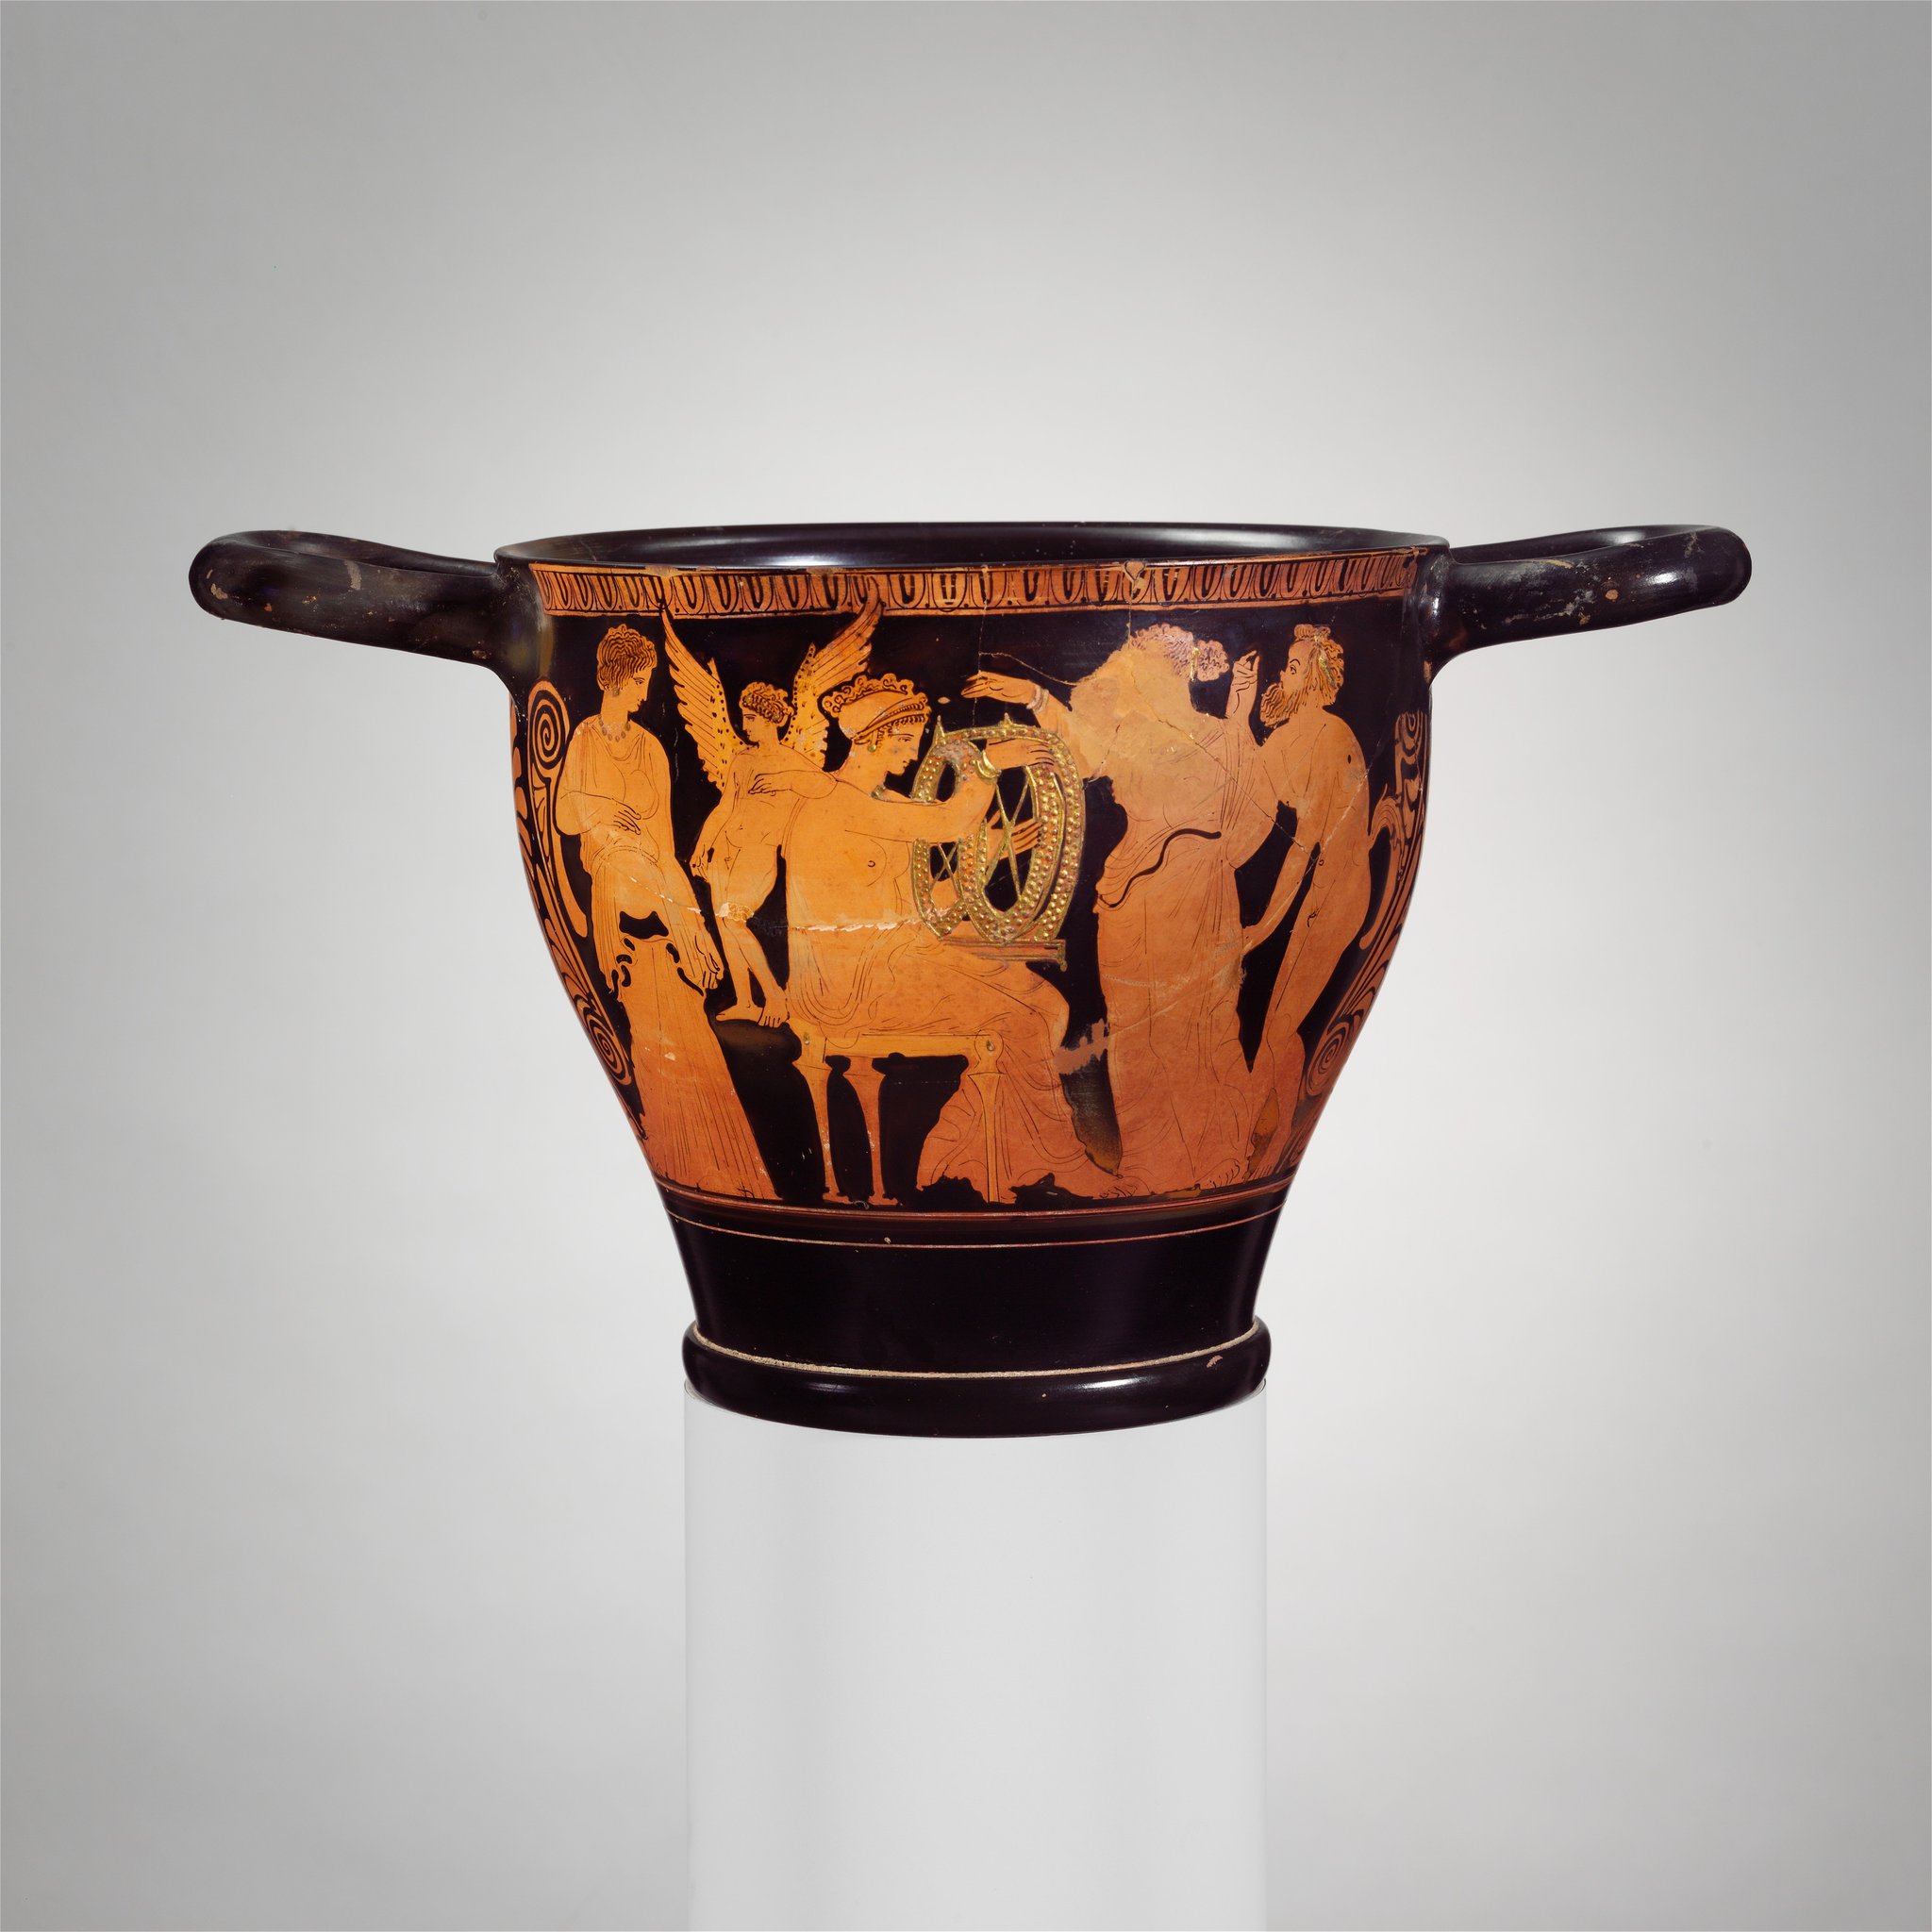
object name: skyphos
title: Terracotta skyphos (deep drinking cup)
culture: greek, attic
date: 350 BCE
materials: terracotta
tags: women,eros,satyrs,baskets